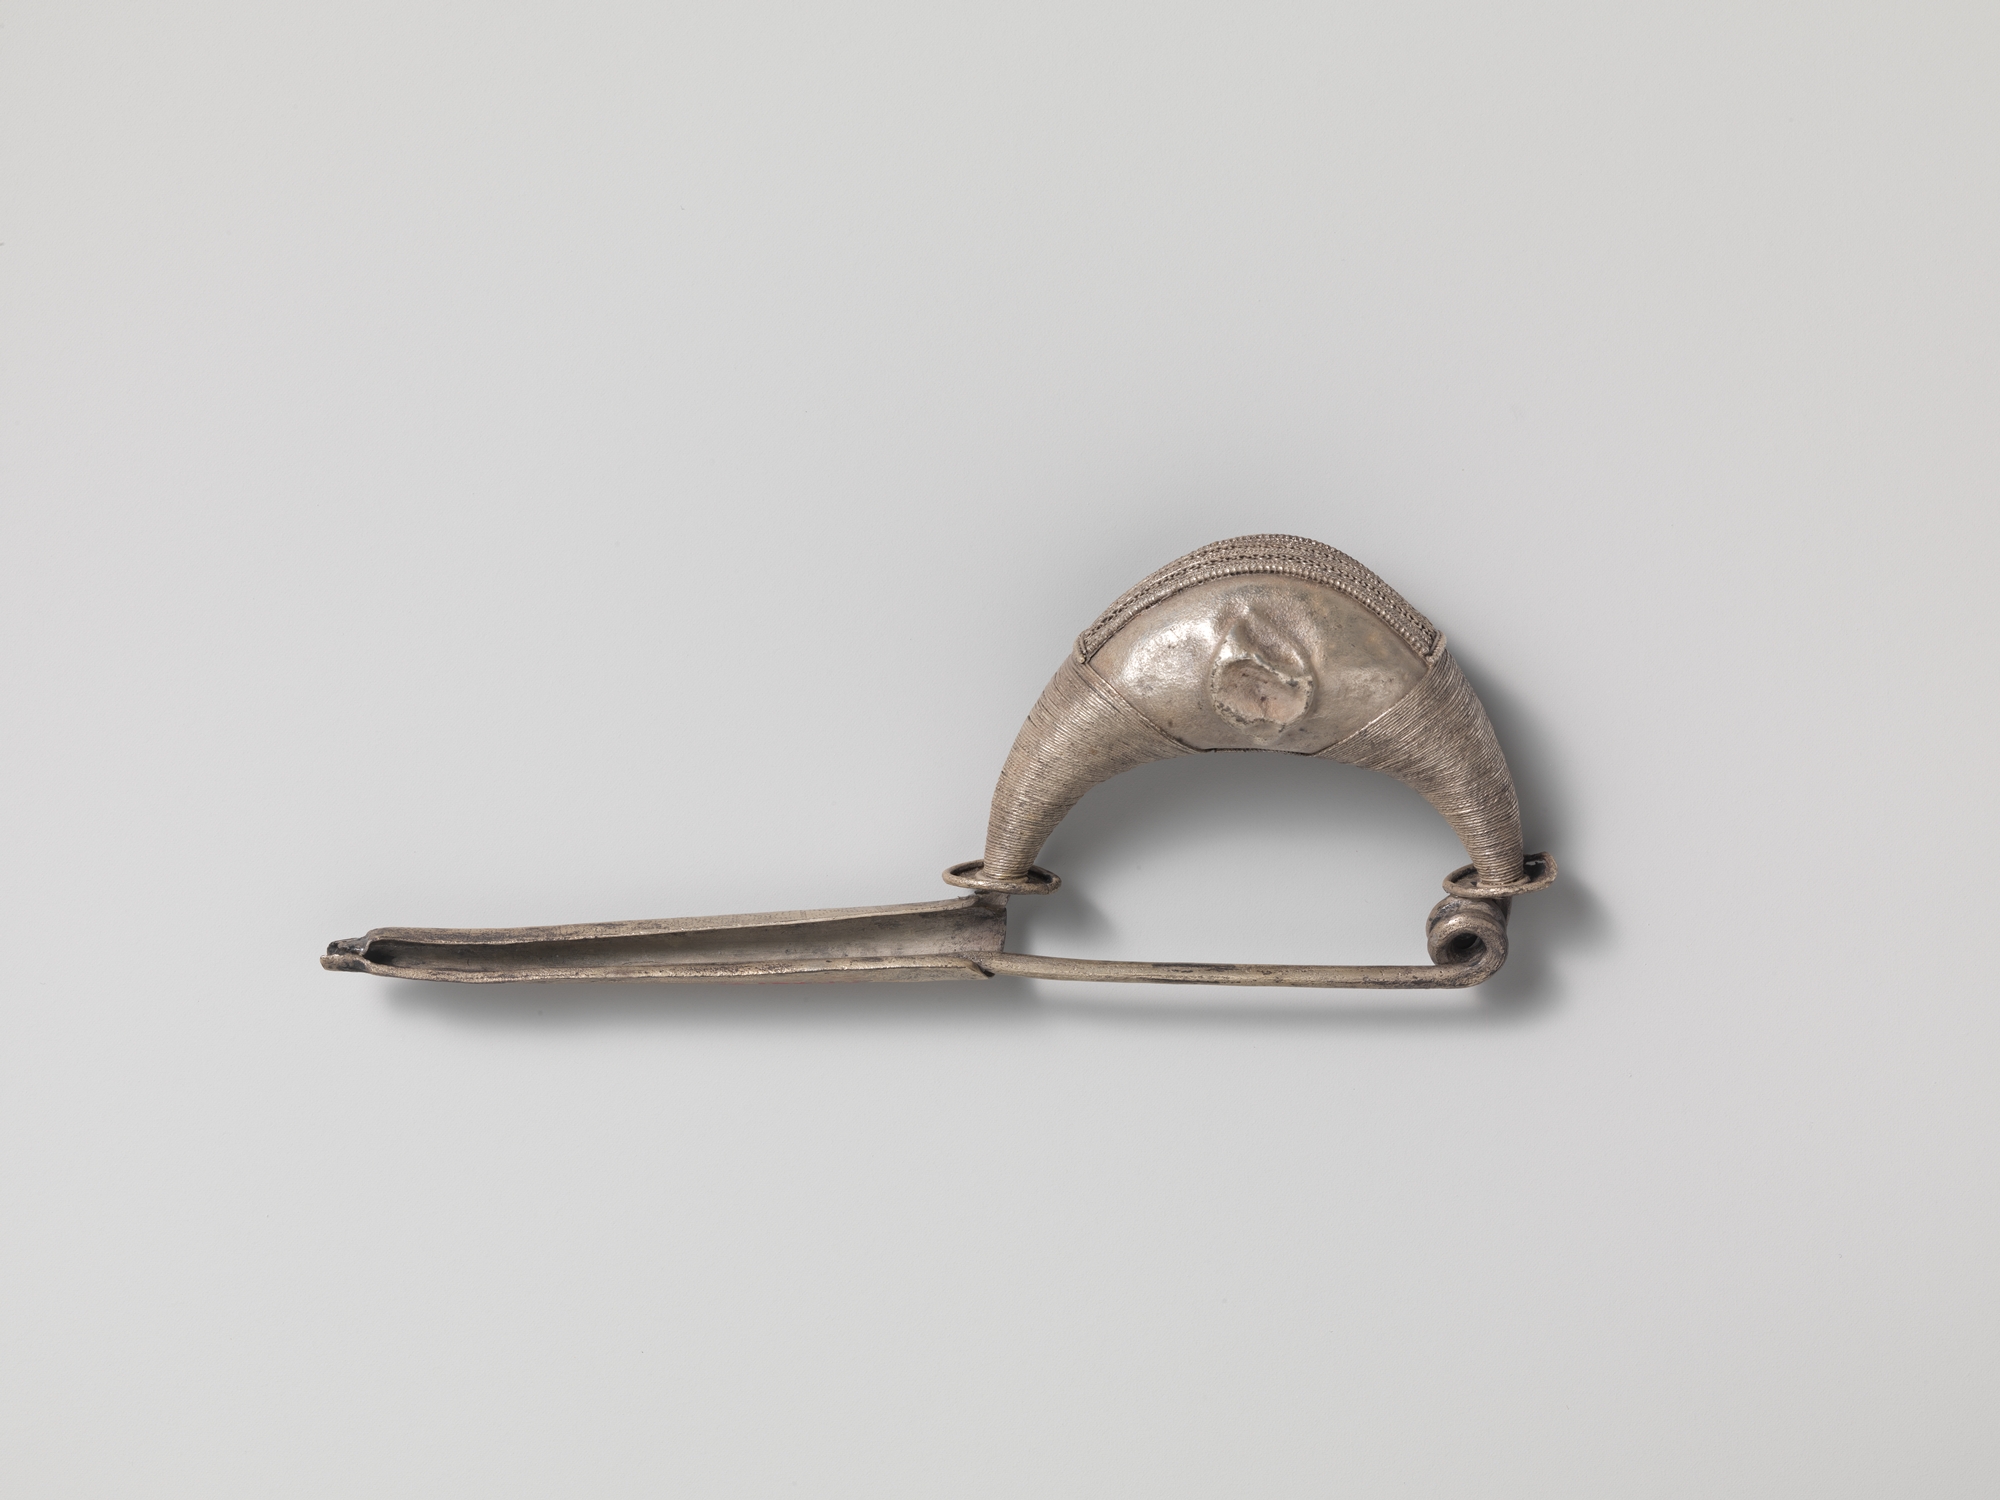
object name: fibula, boat shaped type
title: Silver navicella-type fibula (safety pin)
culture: etruscan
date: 700-501 BCE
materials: silver